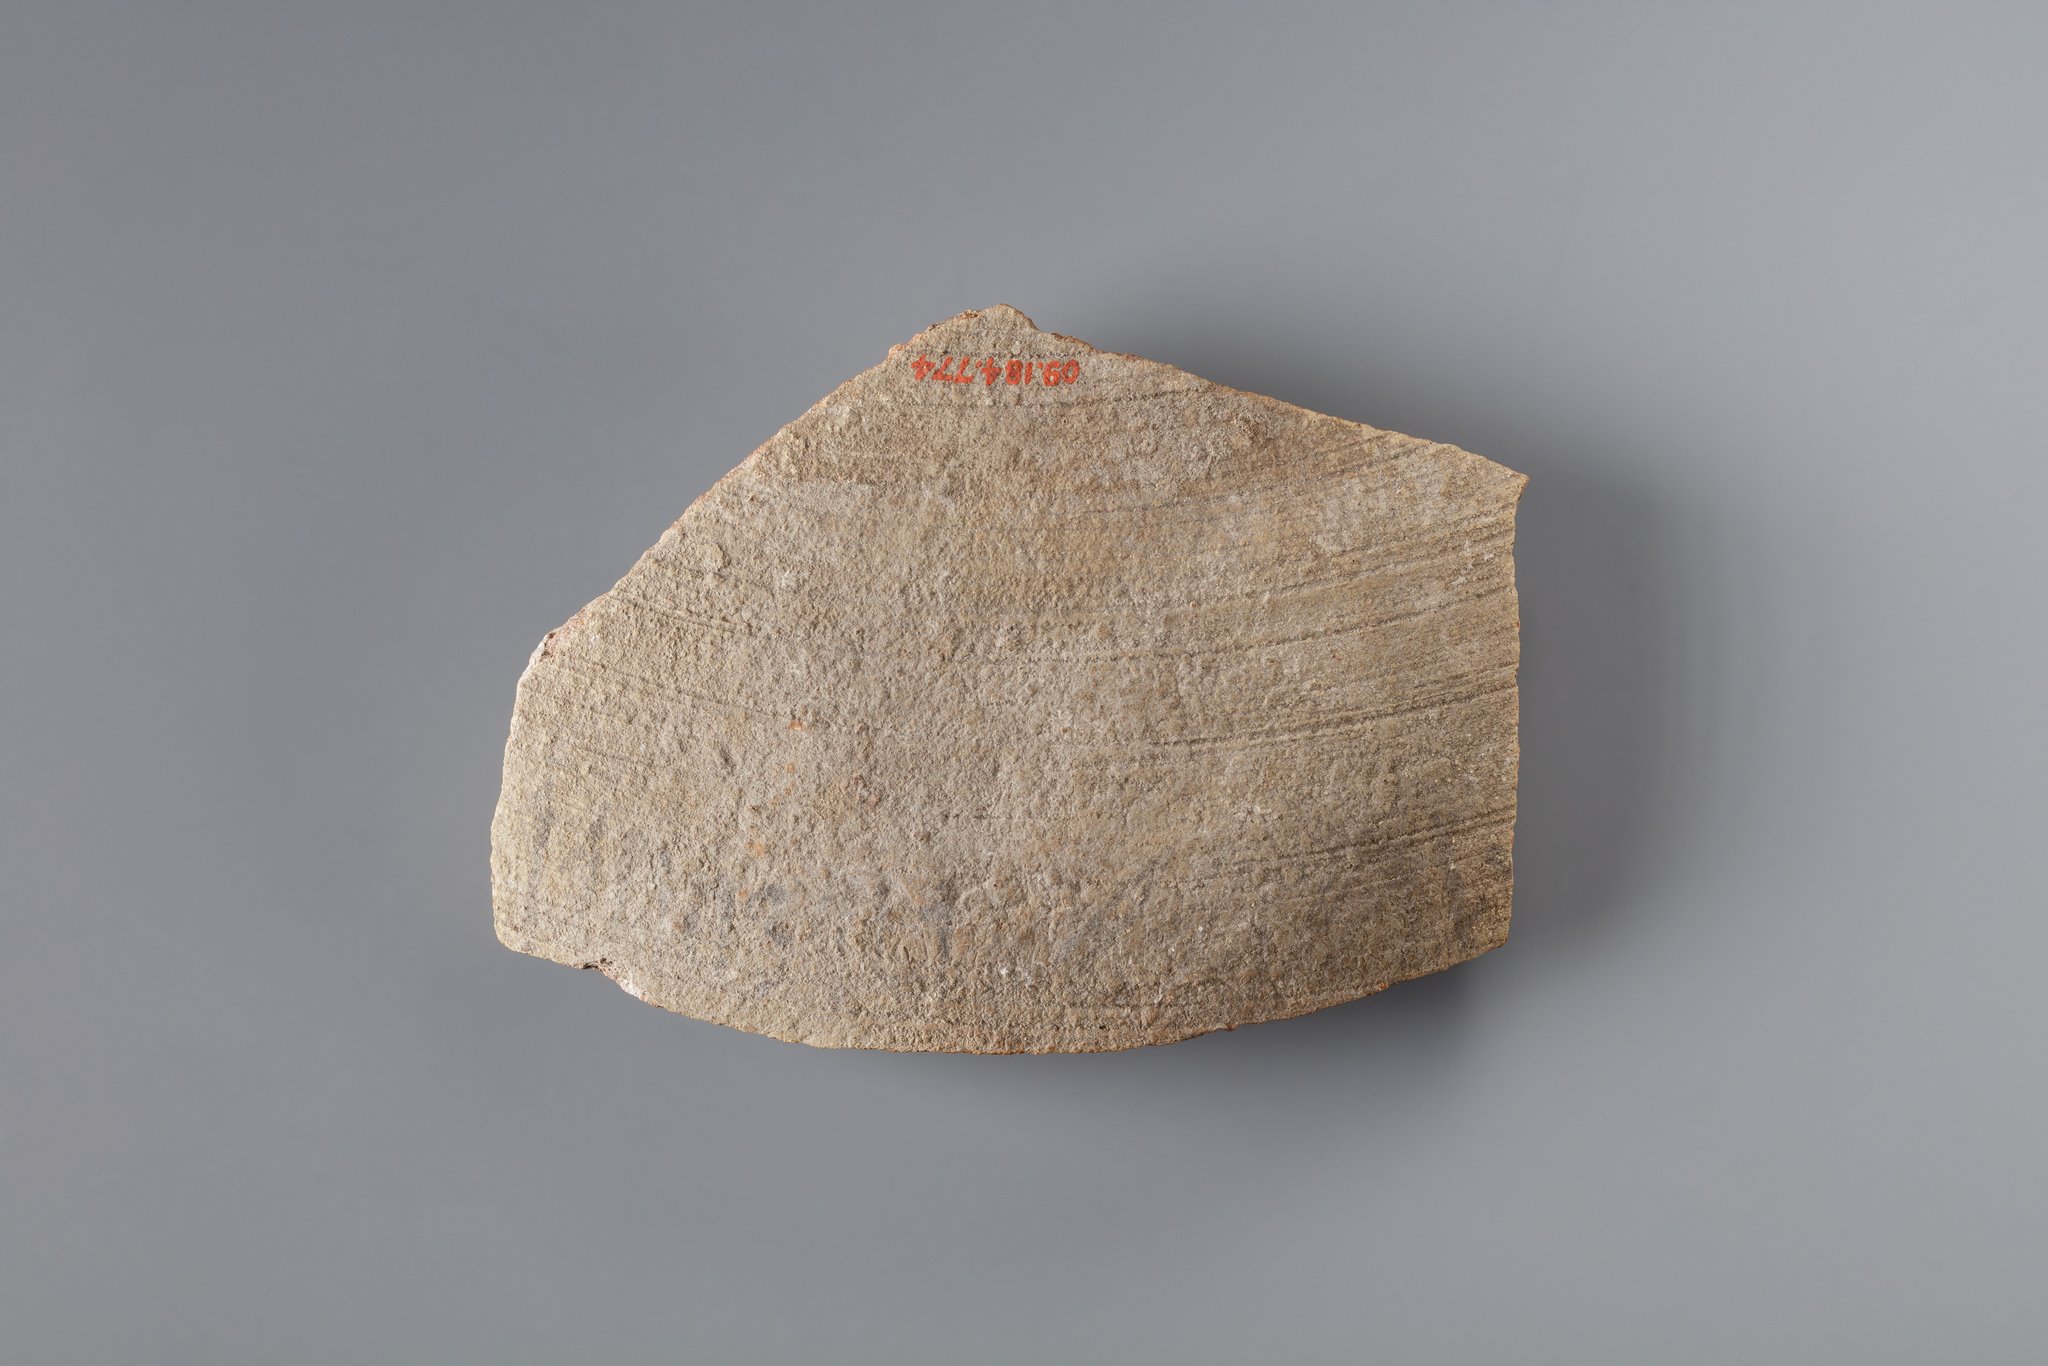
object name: ostracon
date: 1295-1070 BCE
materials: ink, pottery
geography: egypt